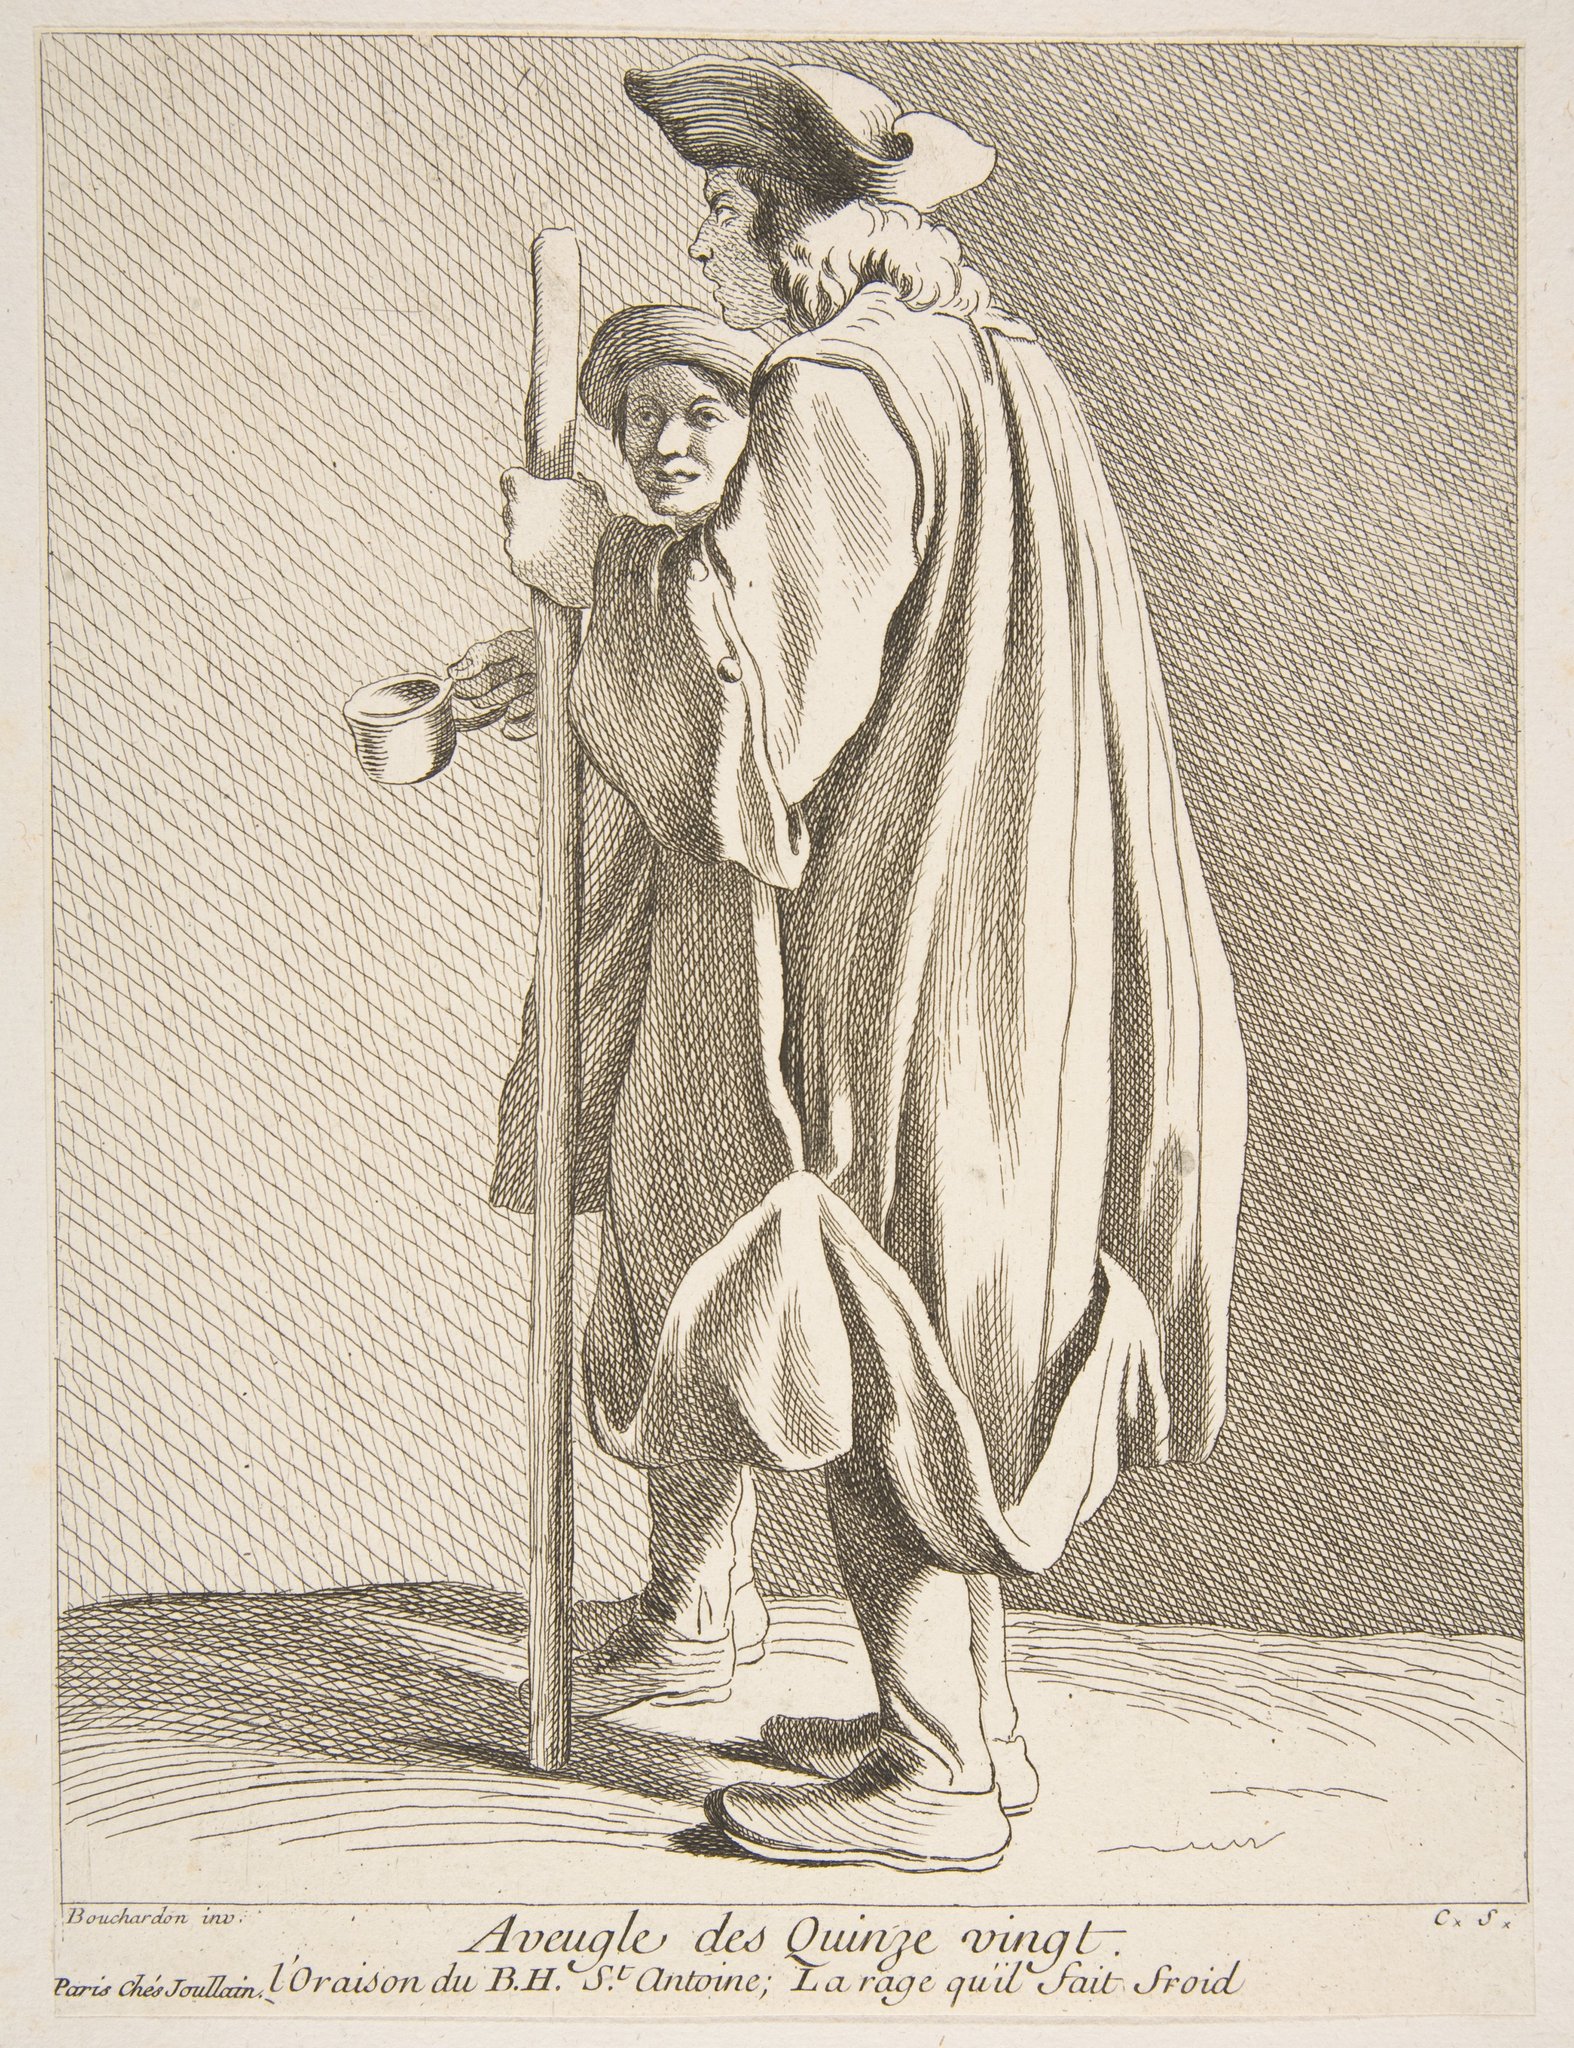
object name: print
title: A Blind Man from the Quinze-Vingts Hospital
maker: anne claude philippe de tubières, comte de caylus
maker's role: artist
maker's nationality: french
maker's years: 1692-1765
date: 1738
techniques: engraving, etching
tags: men